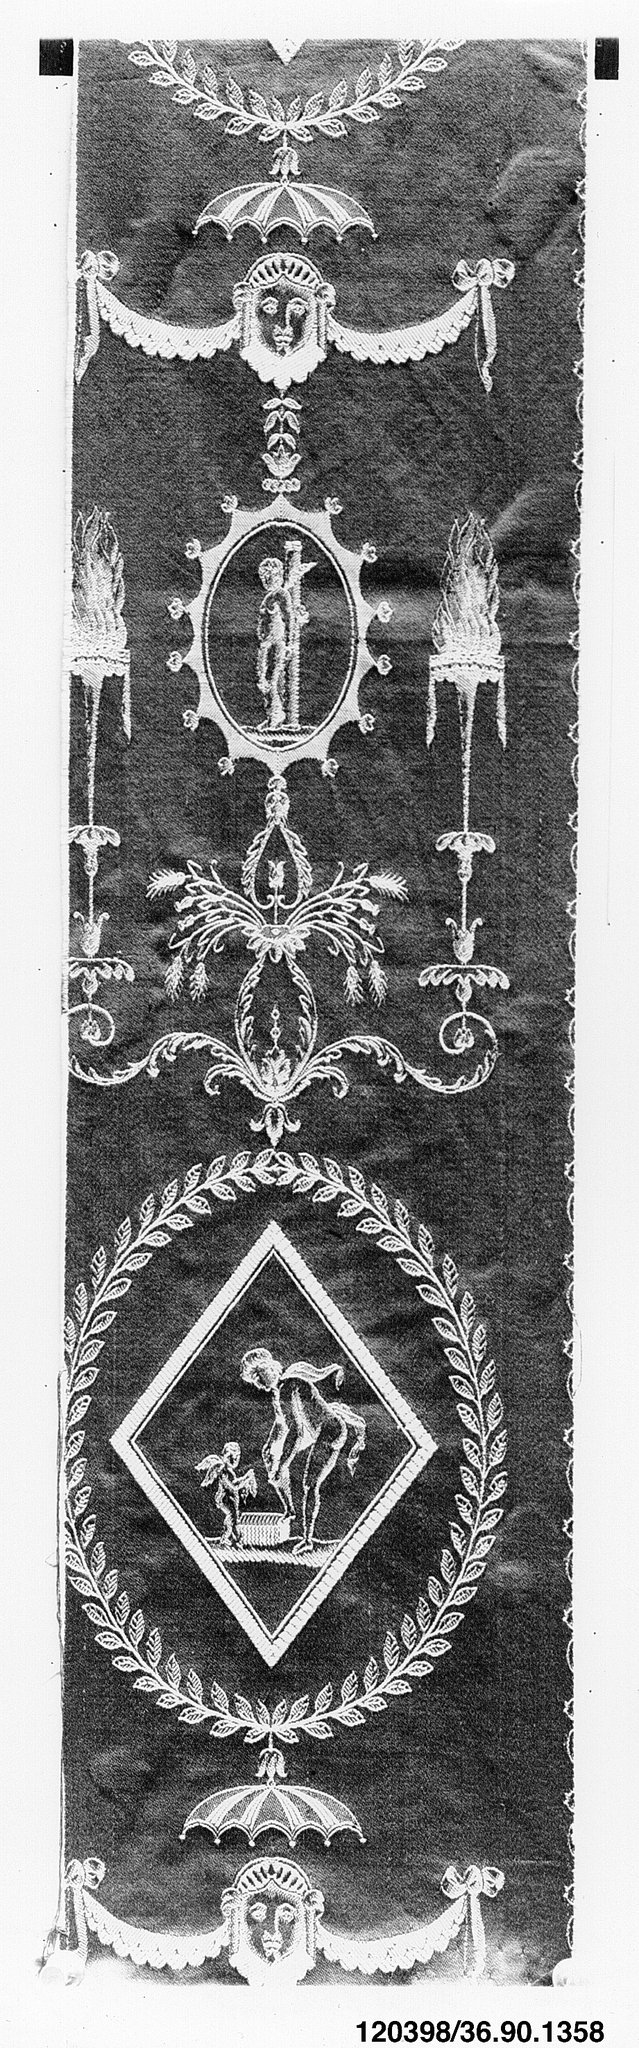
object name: piece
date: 1801-1900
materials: silk